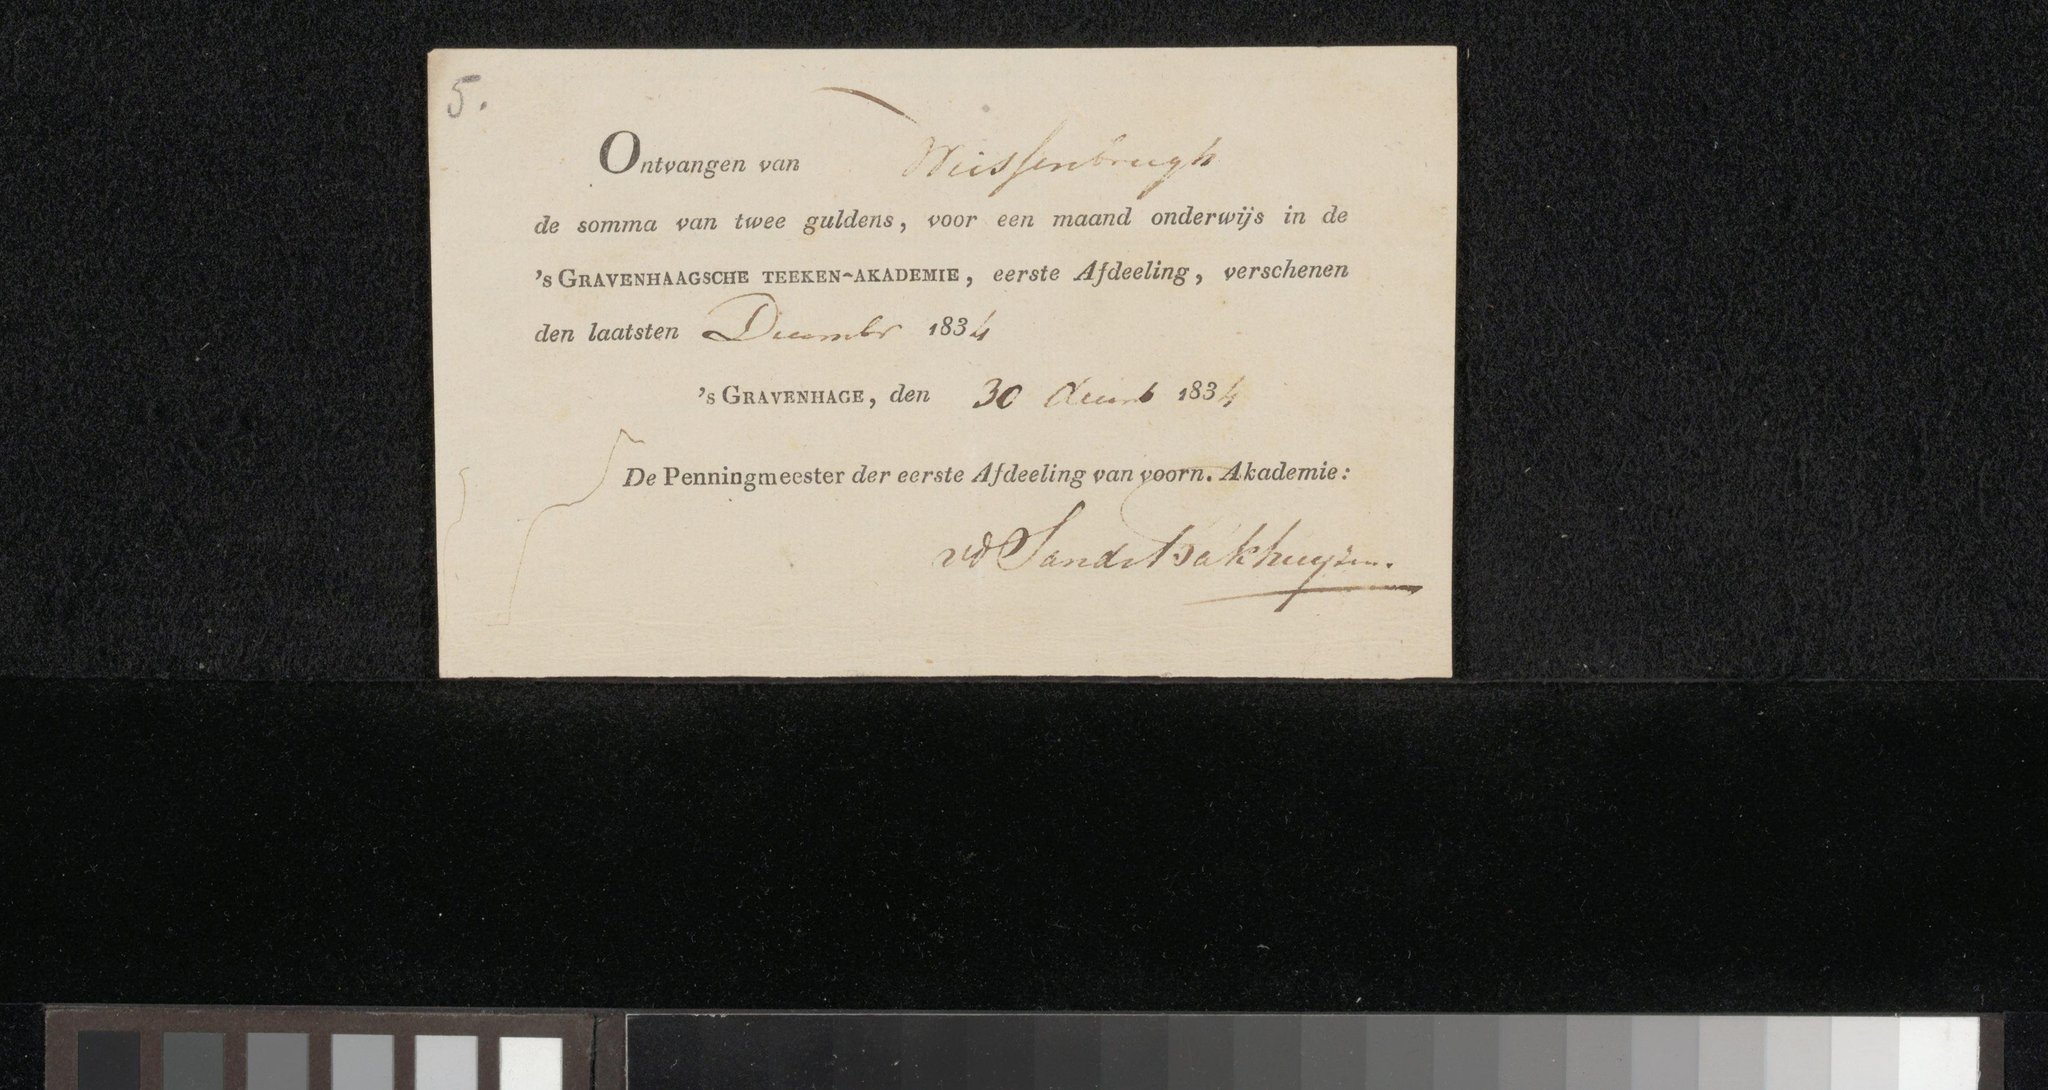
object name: ontvangstbewijs, kwitantie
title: Ontvangstbewijs aan Johan Hendrik Weissenbruch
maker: hendrikus van de sande bakhuyzen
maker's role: draughtsman, painter, print maker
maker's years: 1795-1860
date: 1834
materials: ink, paper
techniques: pen, printing, writing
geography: the hague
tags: painter, johan hendrik weissenbruch, workshop, studio of the artist (in general), money, the hague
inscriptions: collector's mark: Lugt 2233